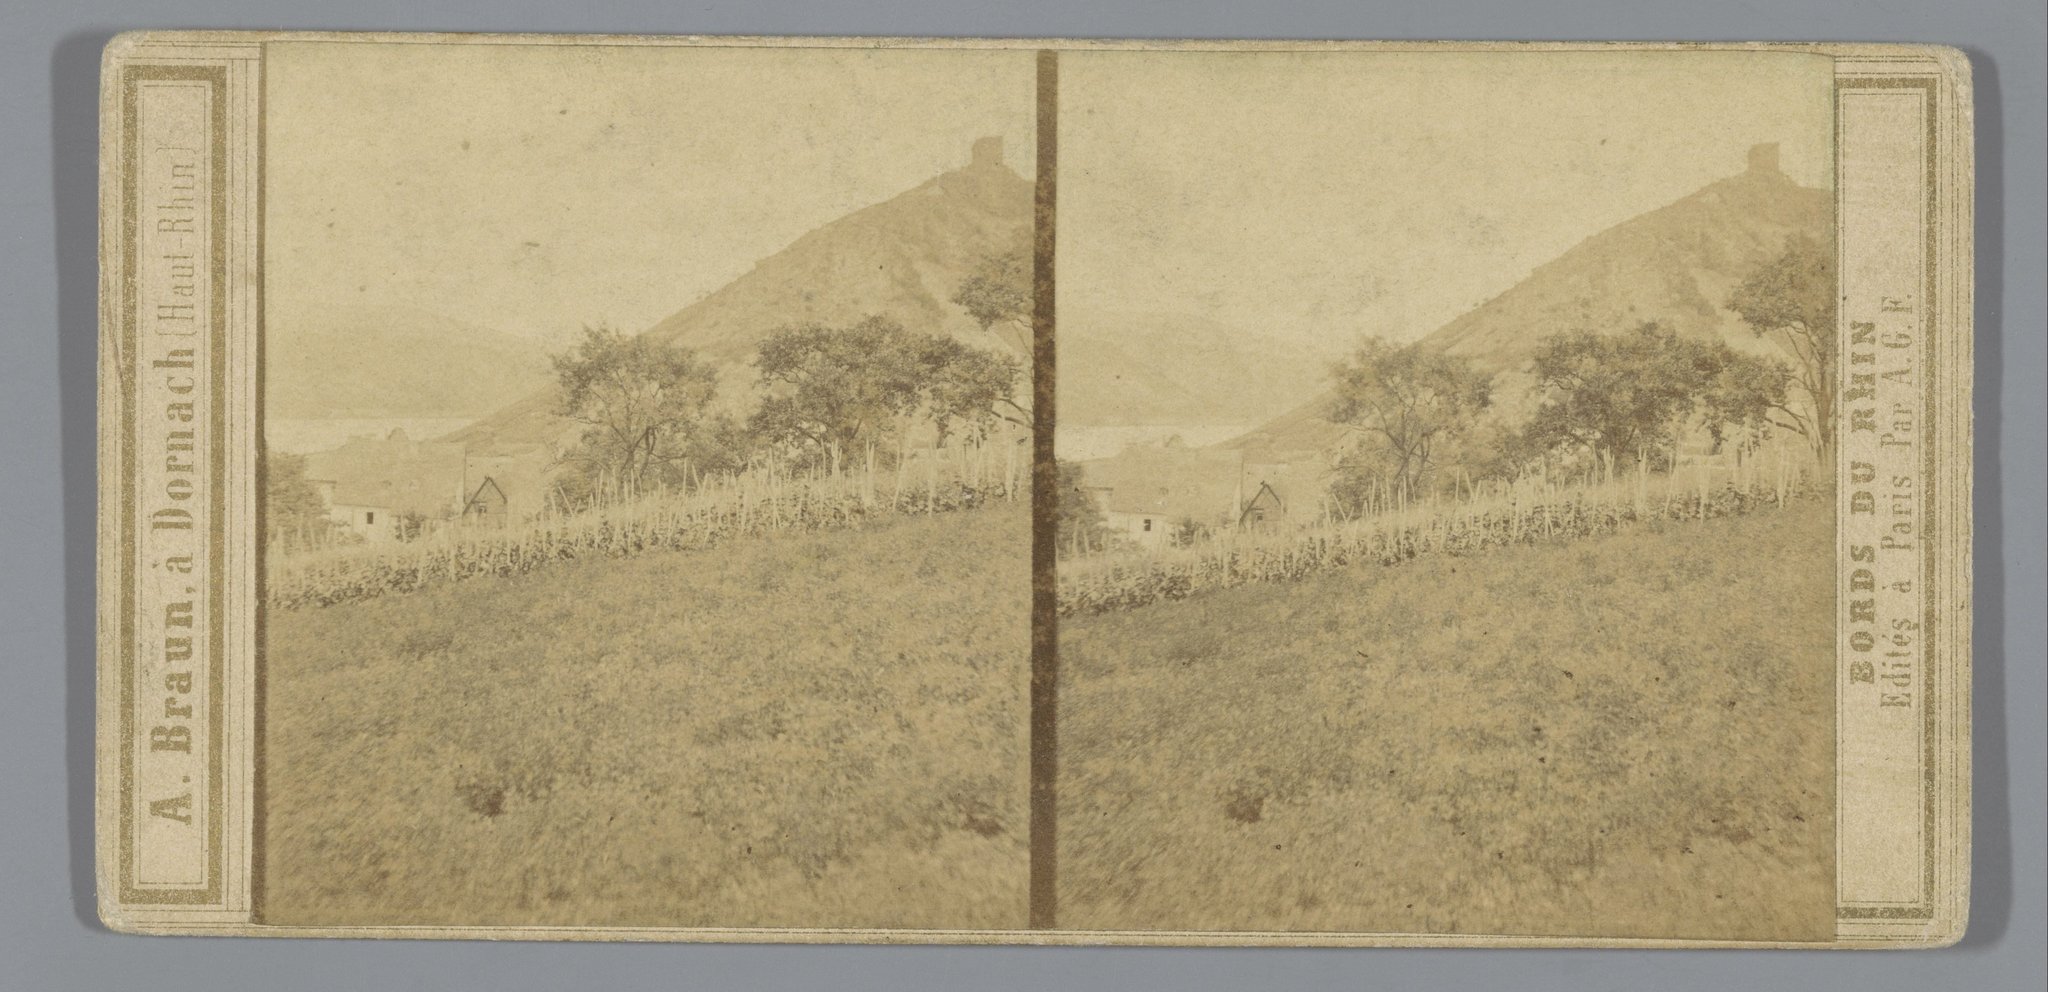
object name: stereograph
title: Bords du Rhin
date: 1860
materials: cardboard, paper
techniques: albumen print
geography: hinterweidenthal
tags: low hill country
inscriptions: number: ‘867.’